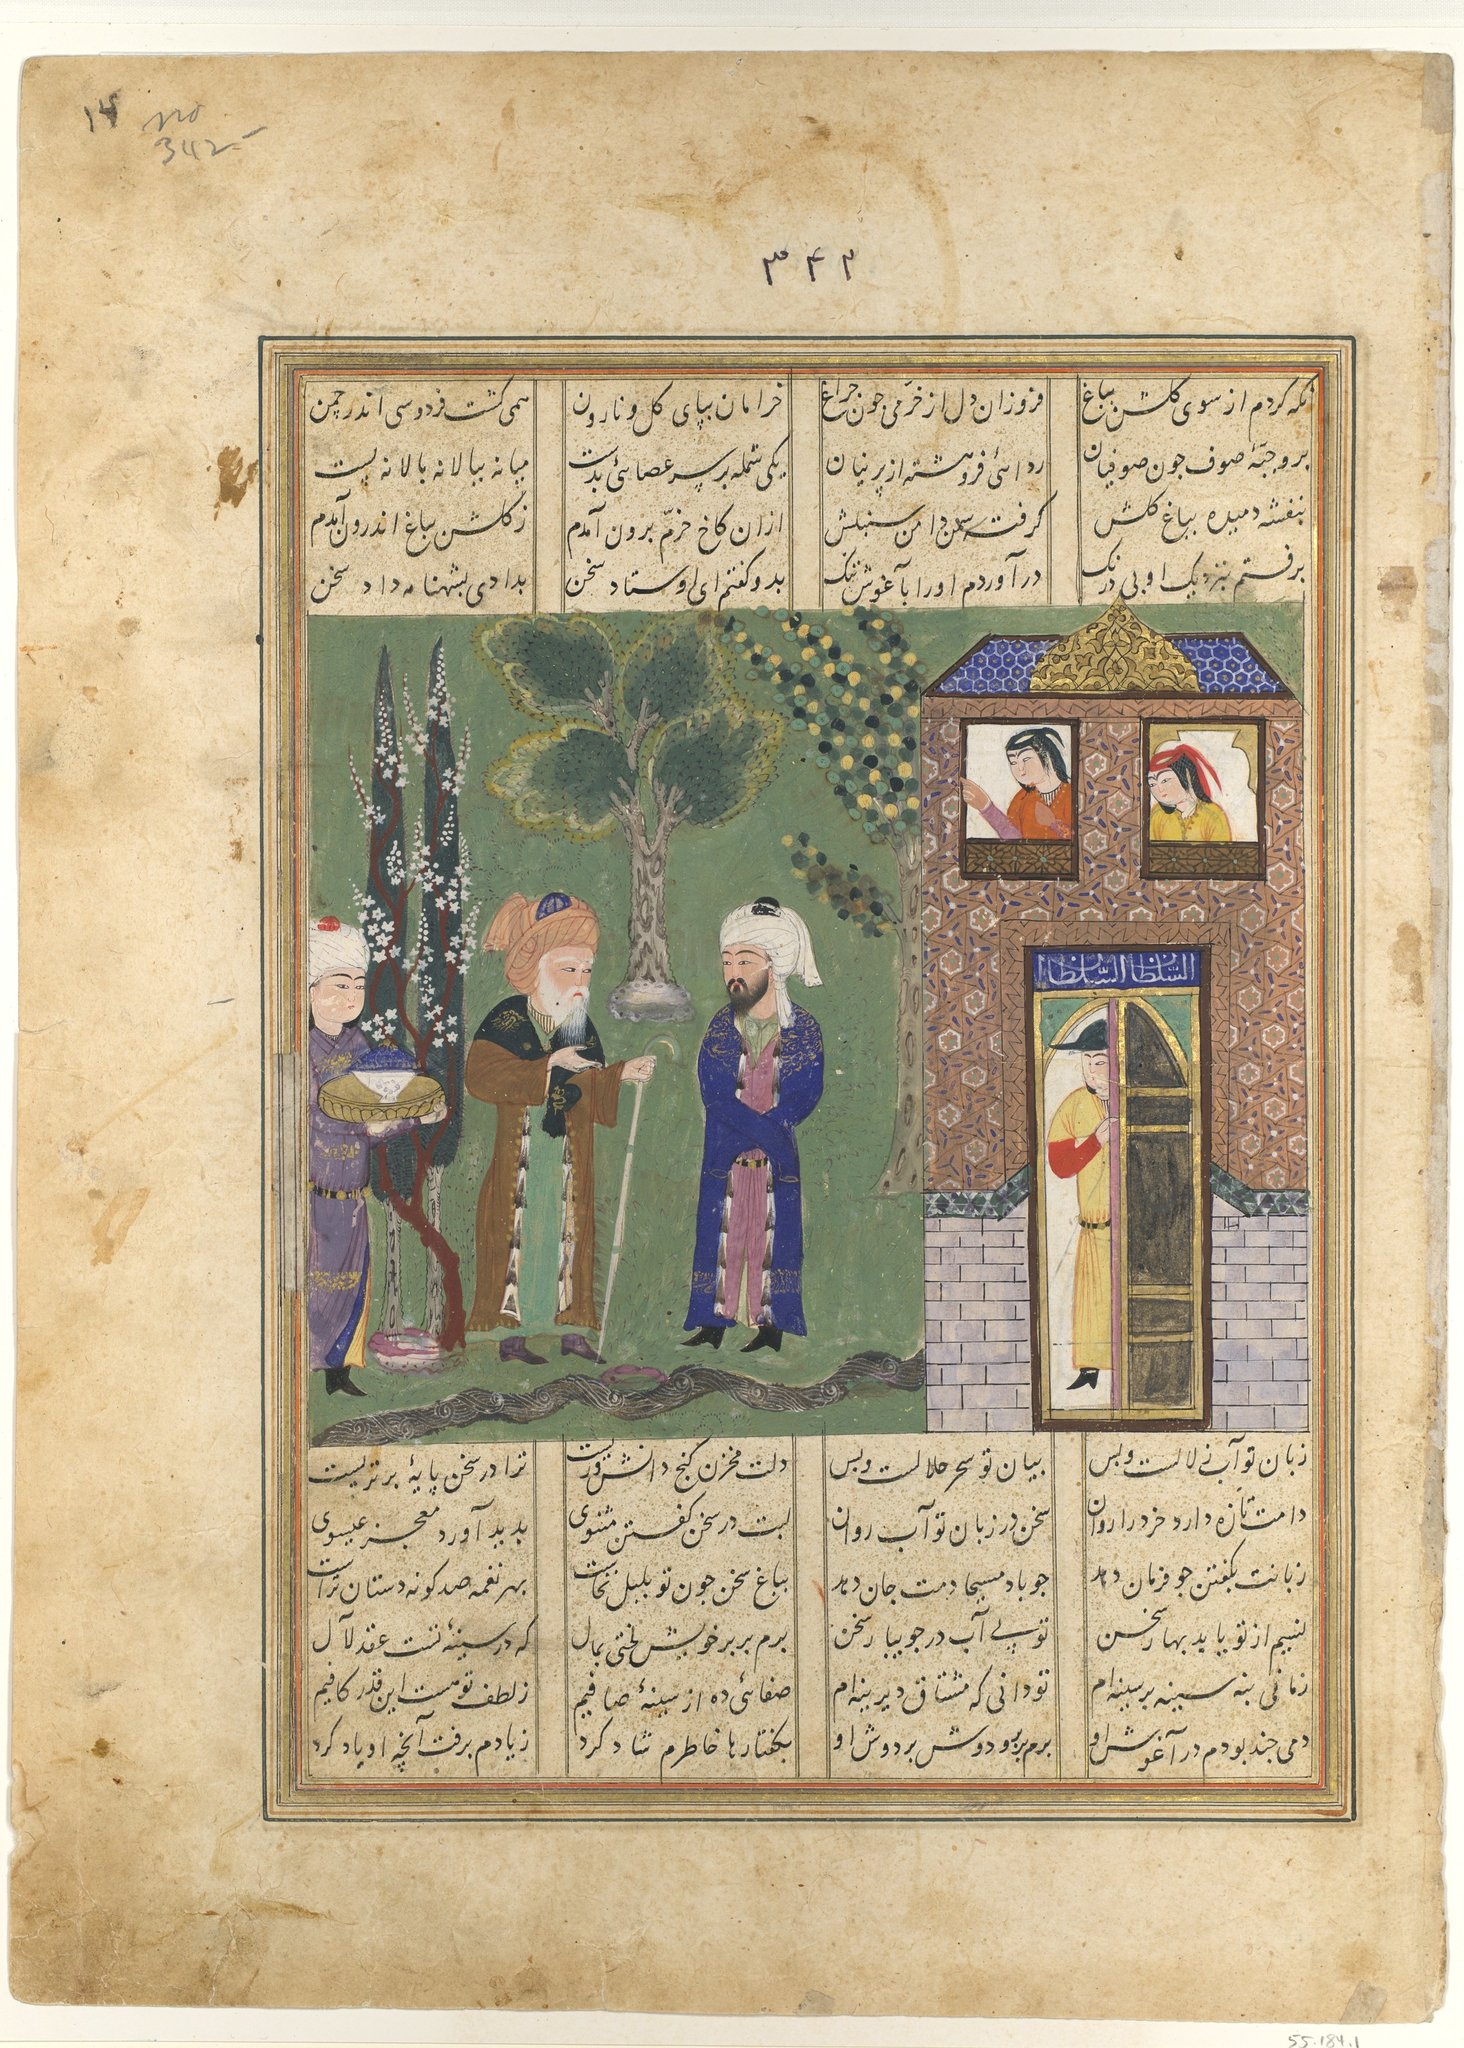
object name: folio from an illustrated manuscript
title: "Three Men Before a Castle", Folio from a Khavarannama (The Book of the East) of ibn Husam al-Din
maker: maulana muhammad ibn husam ad din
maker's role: author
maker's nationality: iranian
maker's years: 1370-1470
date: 1476-1486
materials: gold, ink, paper, watercolor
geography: iran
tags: men